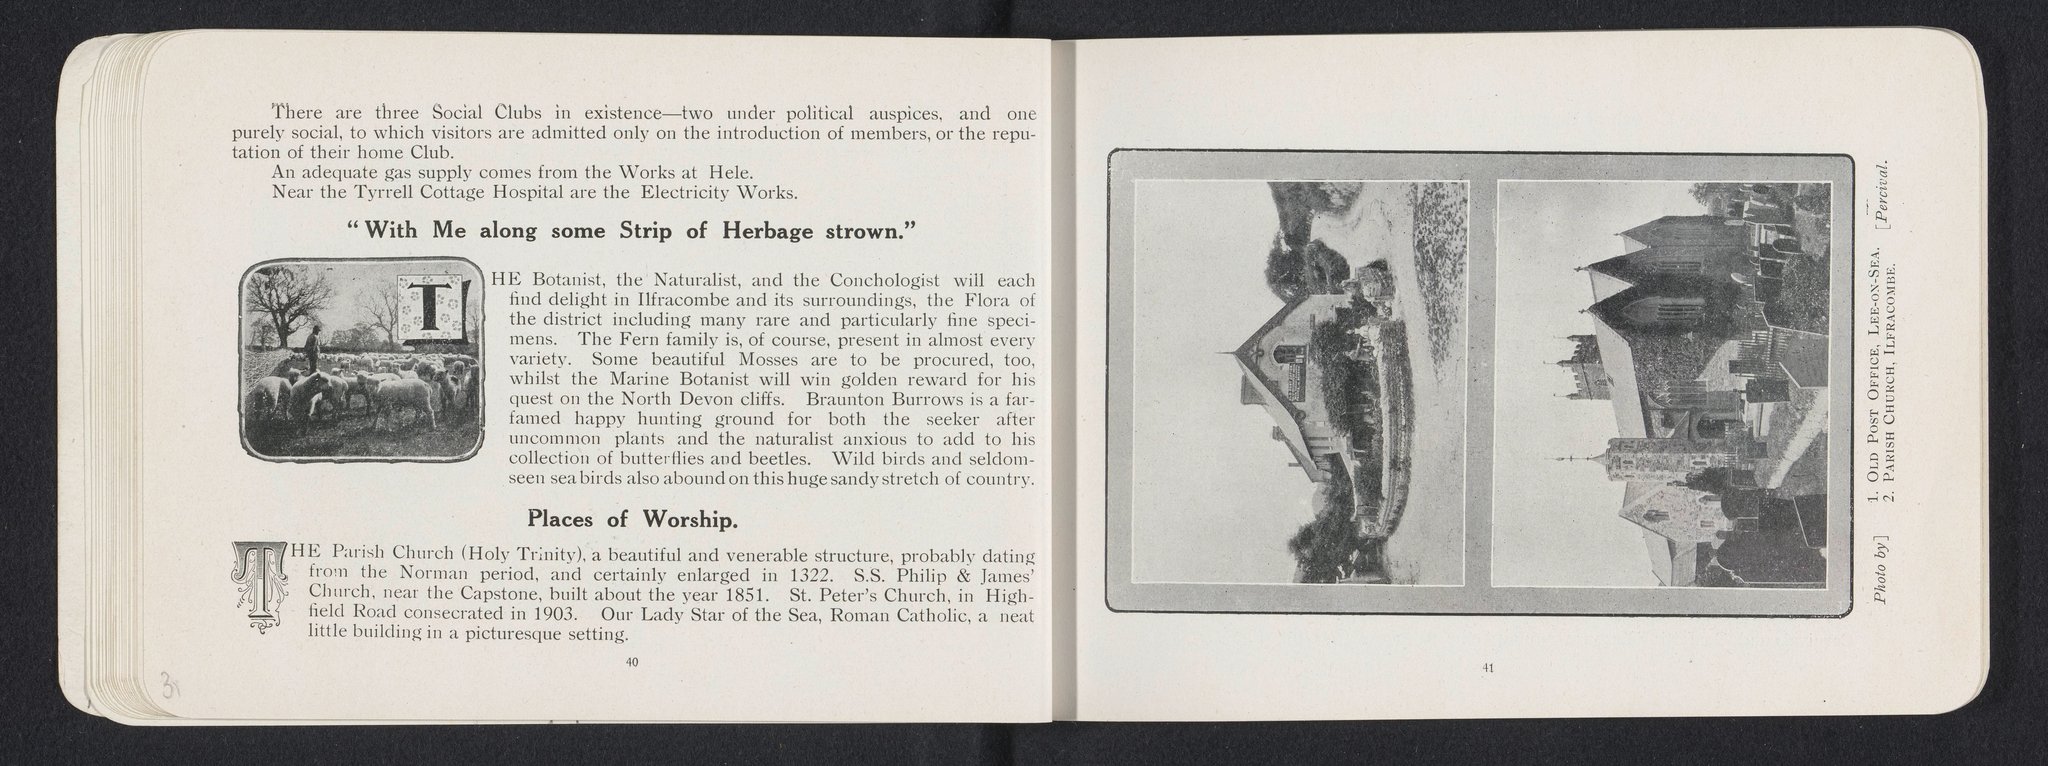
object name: page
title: Capstone Hill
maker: Anonymous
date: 1900-1920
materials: paper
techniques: autotype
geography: ilfracombe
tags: cape (coast)